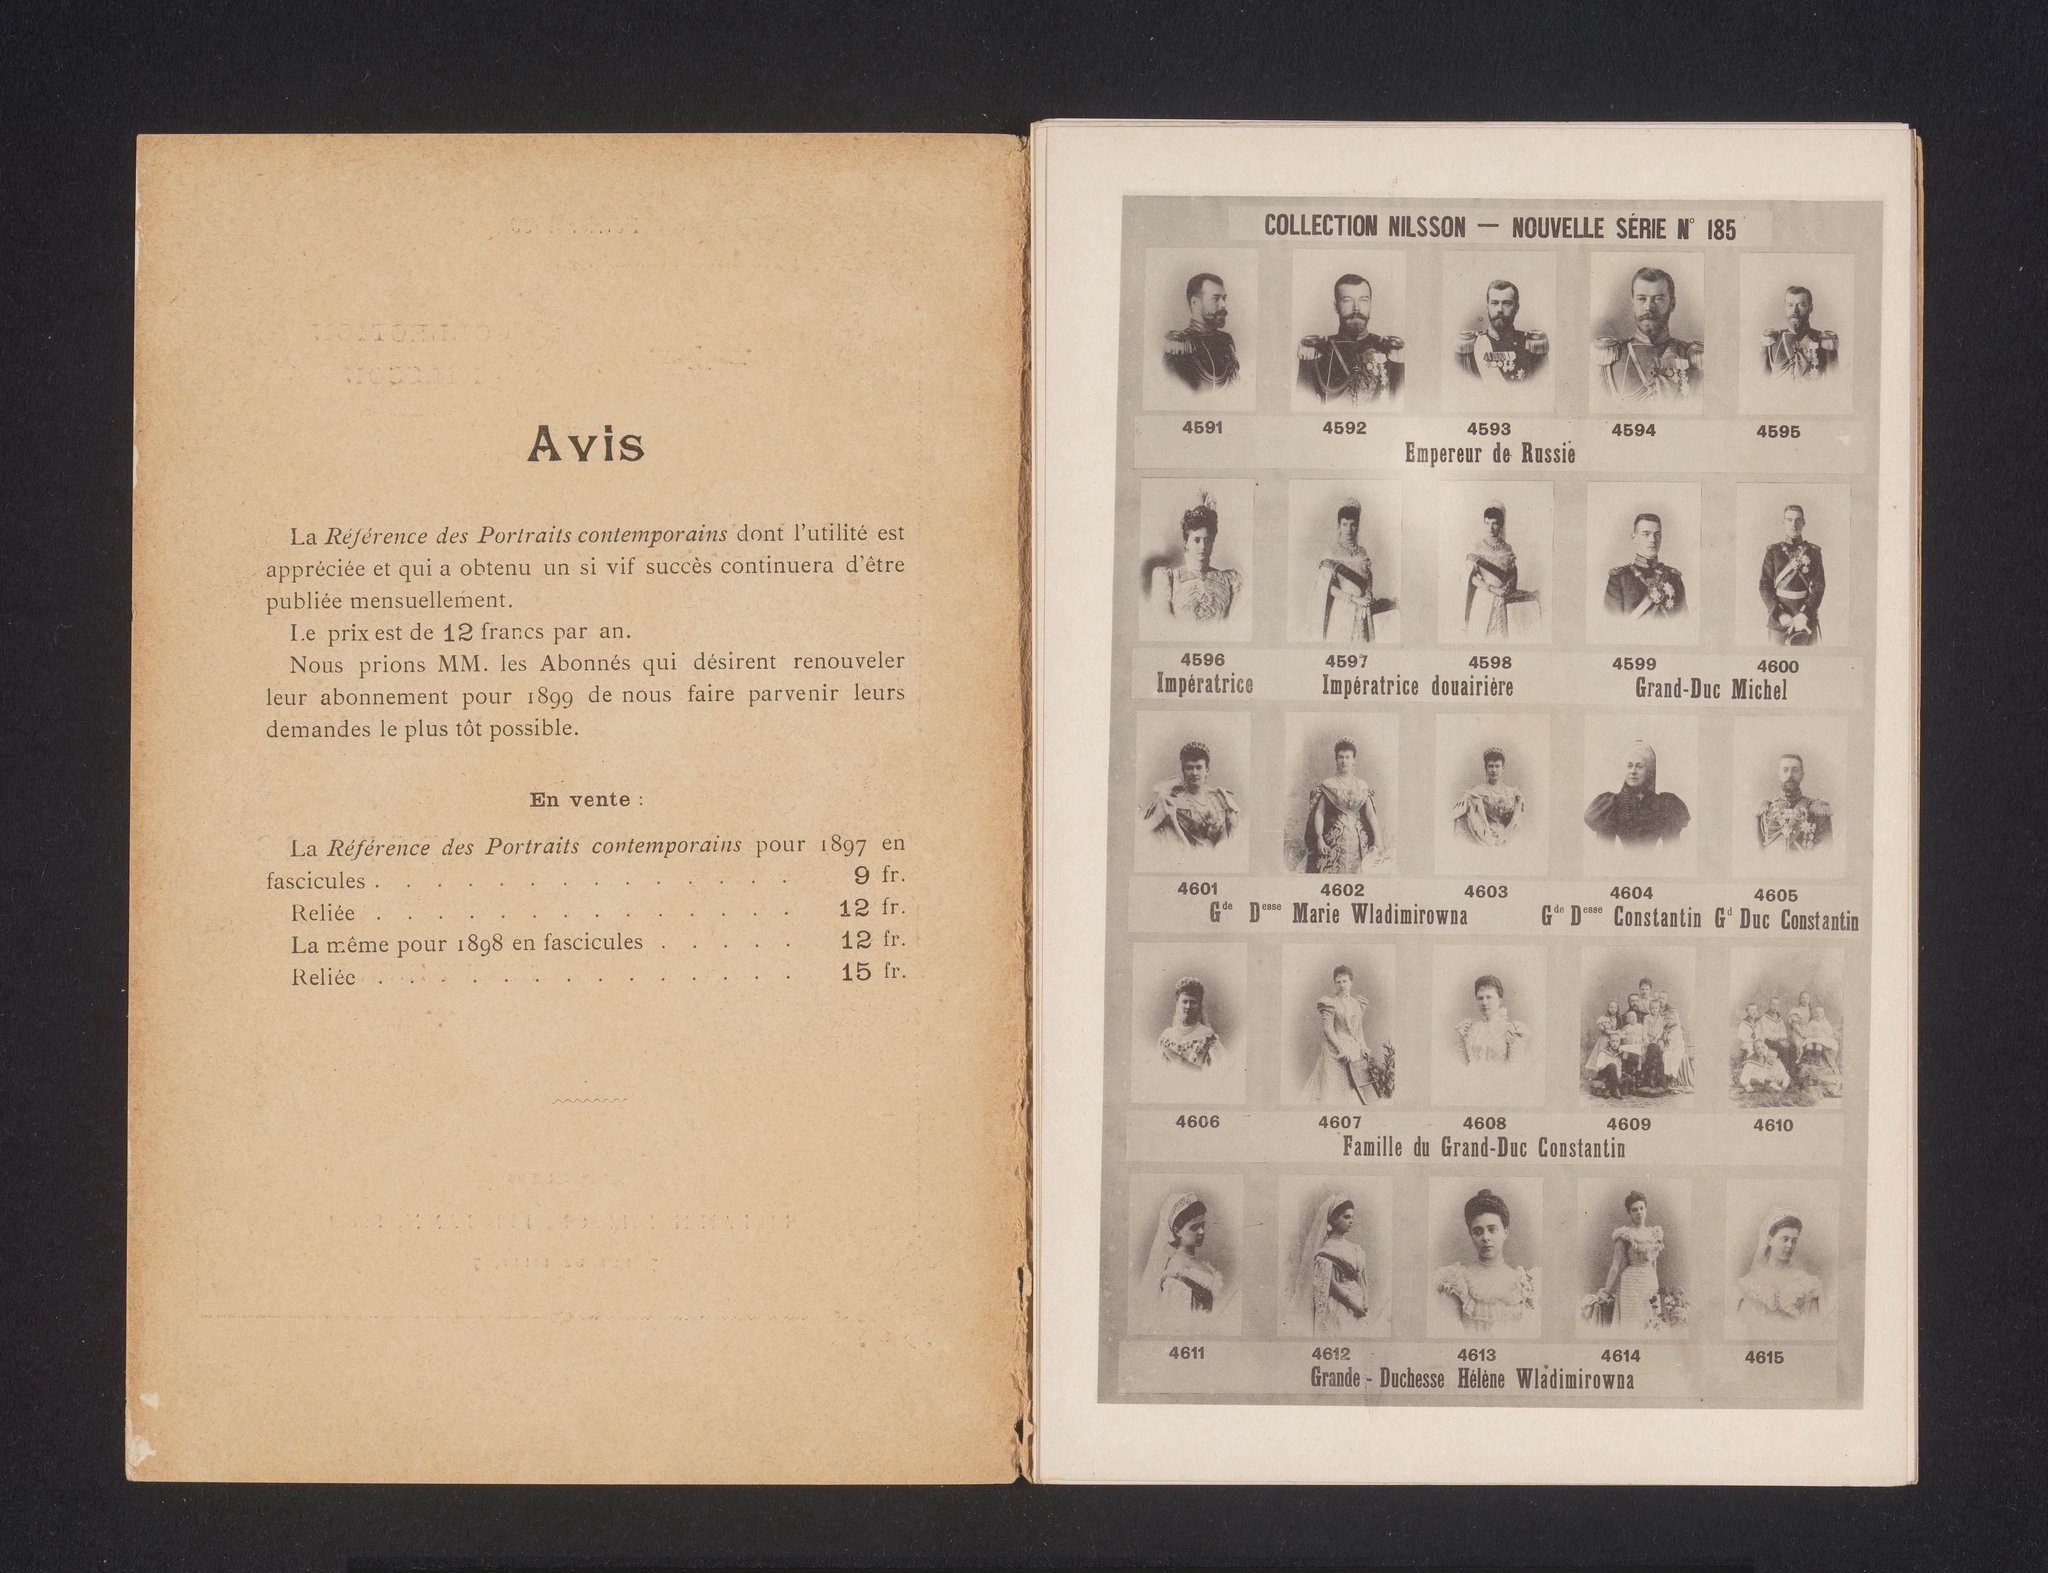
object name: page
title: Collection Nilsson - Nouvelle Série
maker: Anonymous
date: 1894-1899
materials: paper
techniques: photograph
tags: historical persons - bb - woman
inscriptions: inscription: ‘Empereur de Russie/ Impératrice Impératrice douairière Grand-Duc Michel/ Gde Desse Marie Wladimirowna Gde Desse Constantin Gd Duc Constantin/ Famille du Grand-Duc Constantin/ Grande-Duchesse Hélène Wladimirowna’, number: ‘No 185’